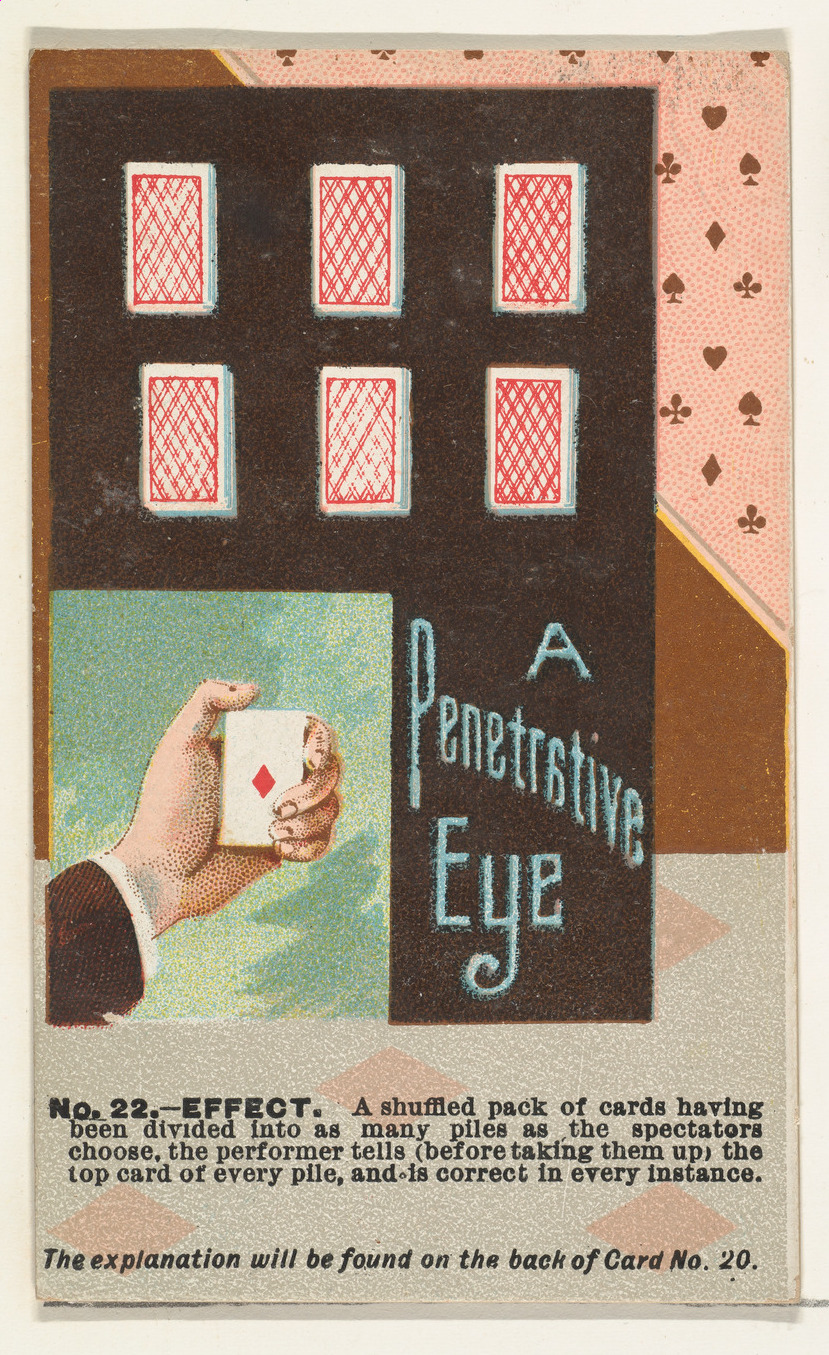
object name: print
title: Number 22, A Penetrative Eye, from the Tricks with Cards series (N138) issued by W. Duke, Sons & Co. to promote Honest Long Cut Tobacco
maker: w. duke, sons & co.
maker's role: publisher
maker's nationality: american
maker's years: 1870-1920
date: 1887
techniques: color lithograph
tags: hands,magic,playing cards